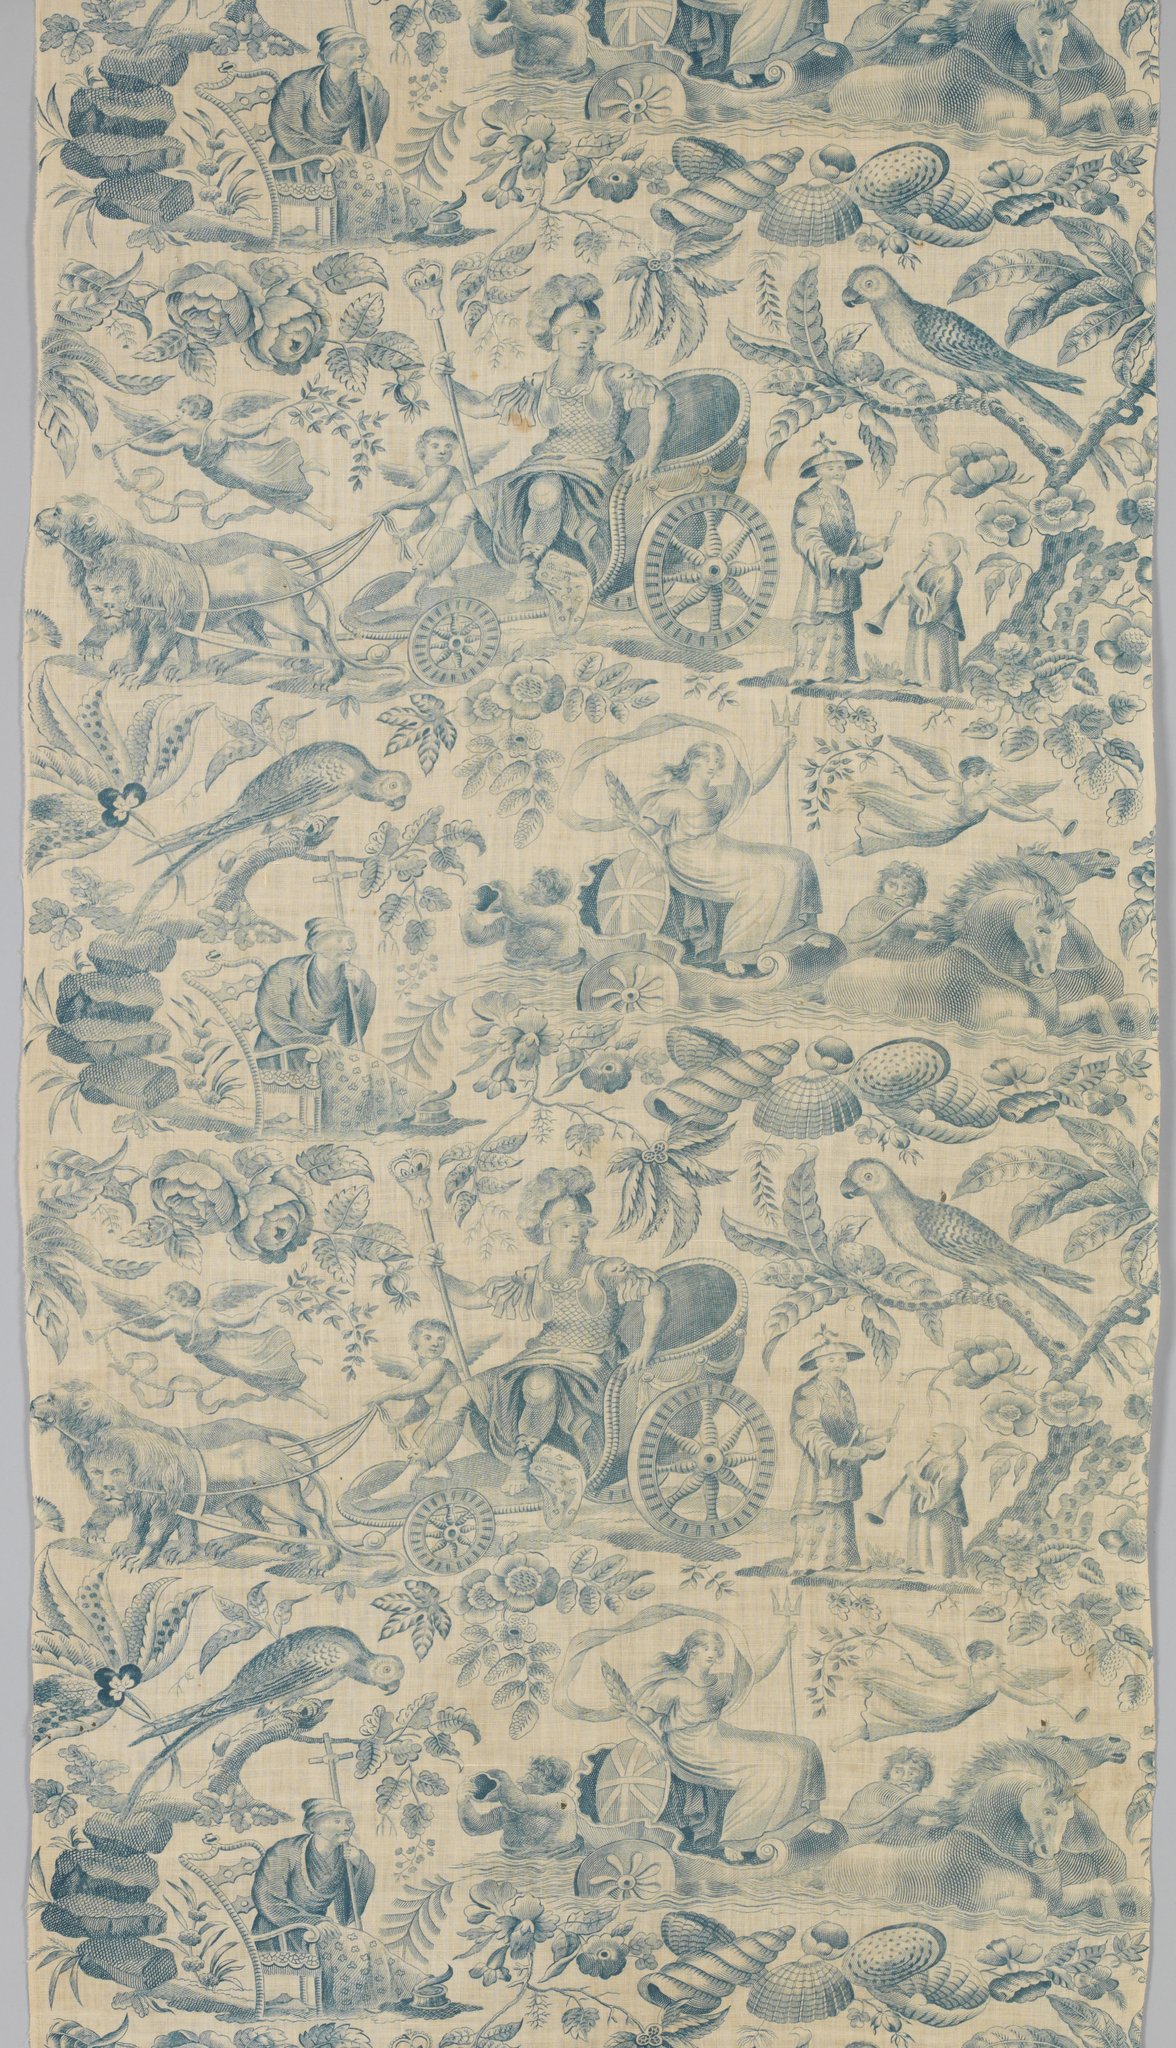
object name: piece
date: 1801-1833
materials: cotton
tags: birds,chinoiserie,putti,lions,chariots